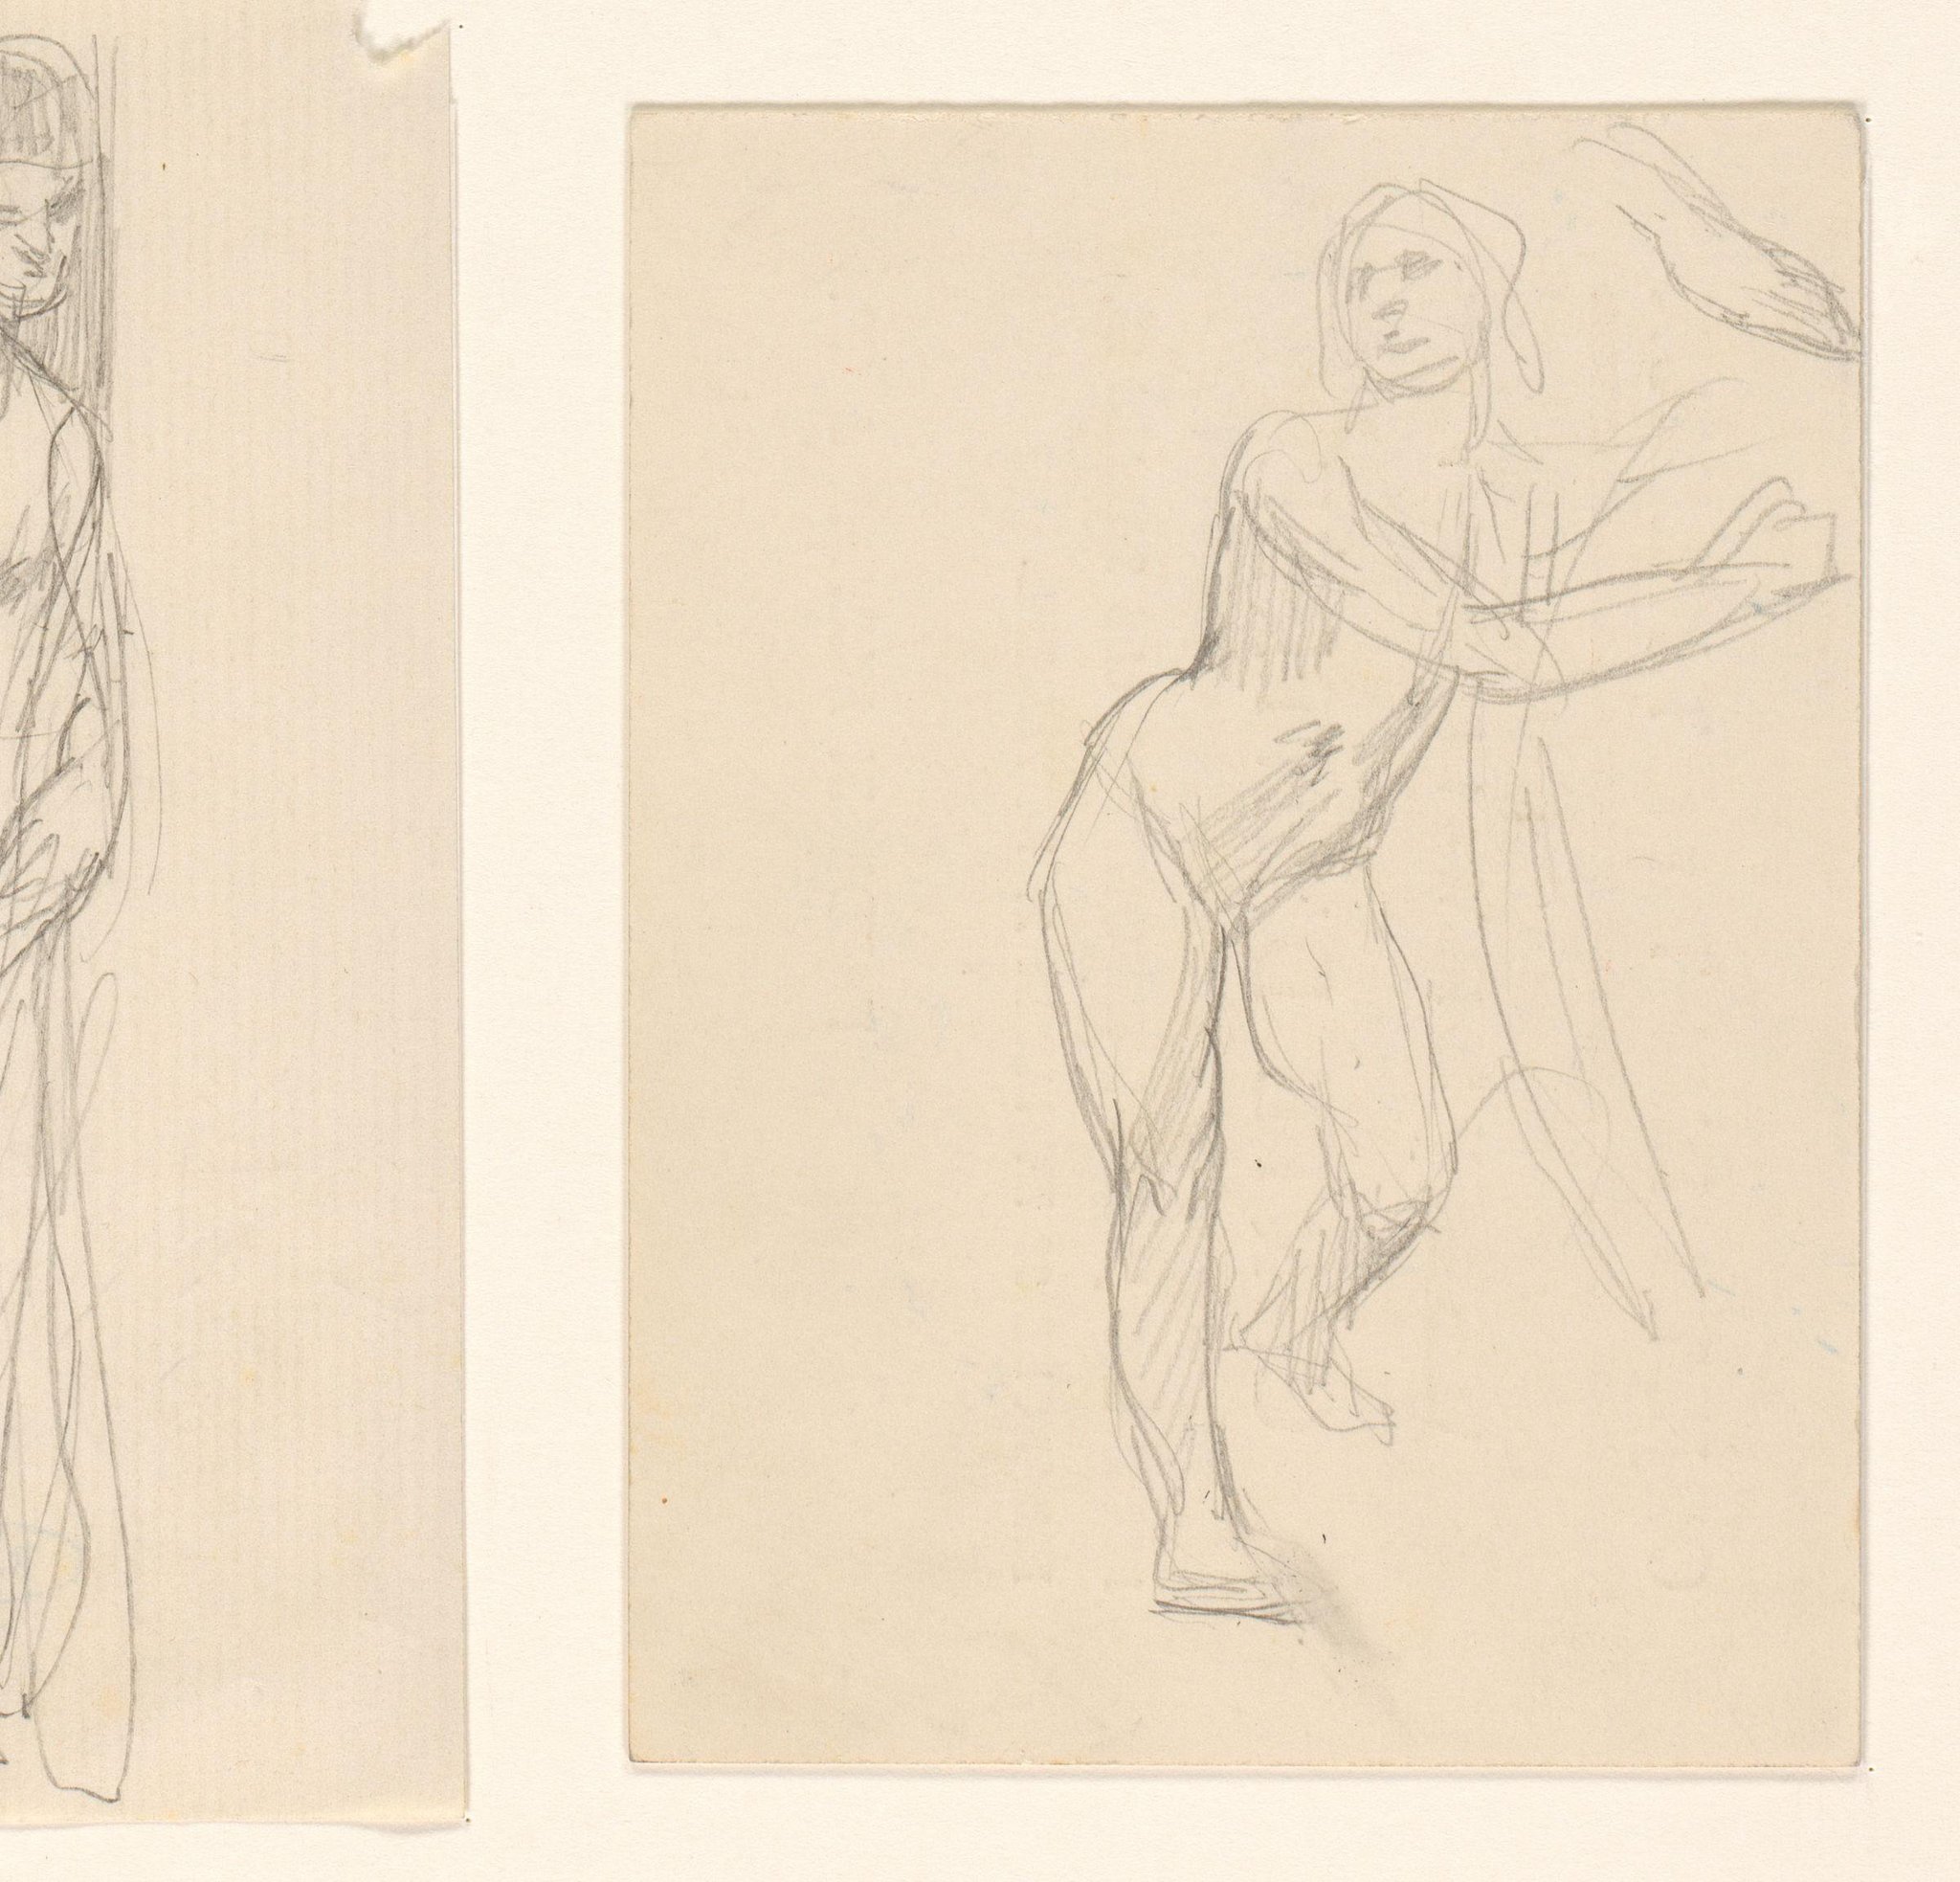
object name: drawing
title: Figuurstudie van een staande naakte vrouw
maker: august allebé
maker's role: draughtsman, print maker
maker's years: 1838-1927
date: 1848-1927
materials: paper, pencil